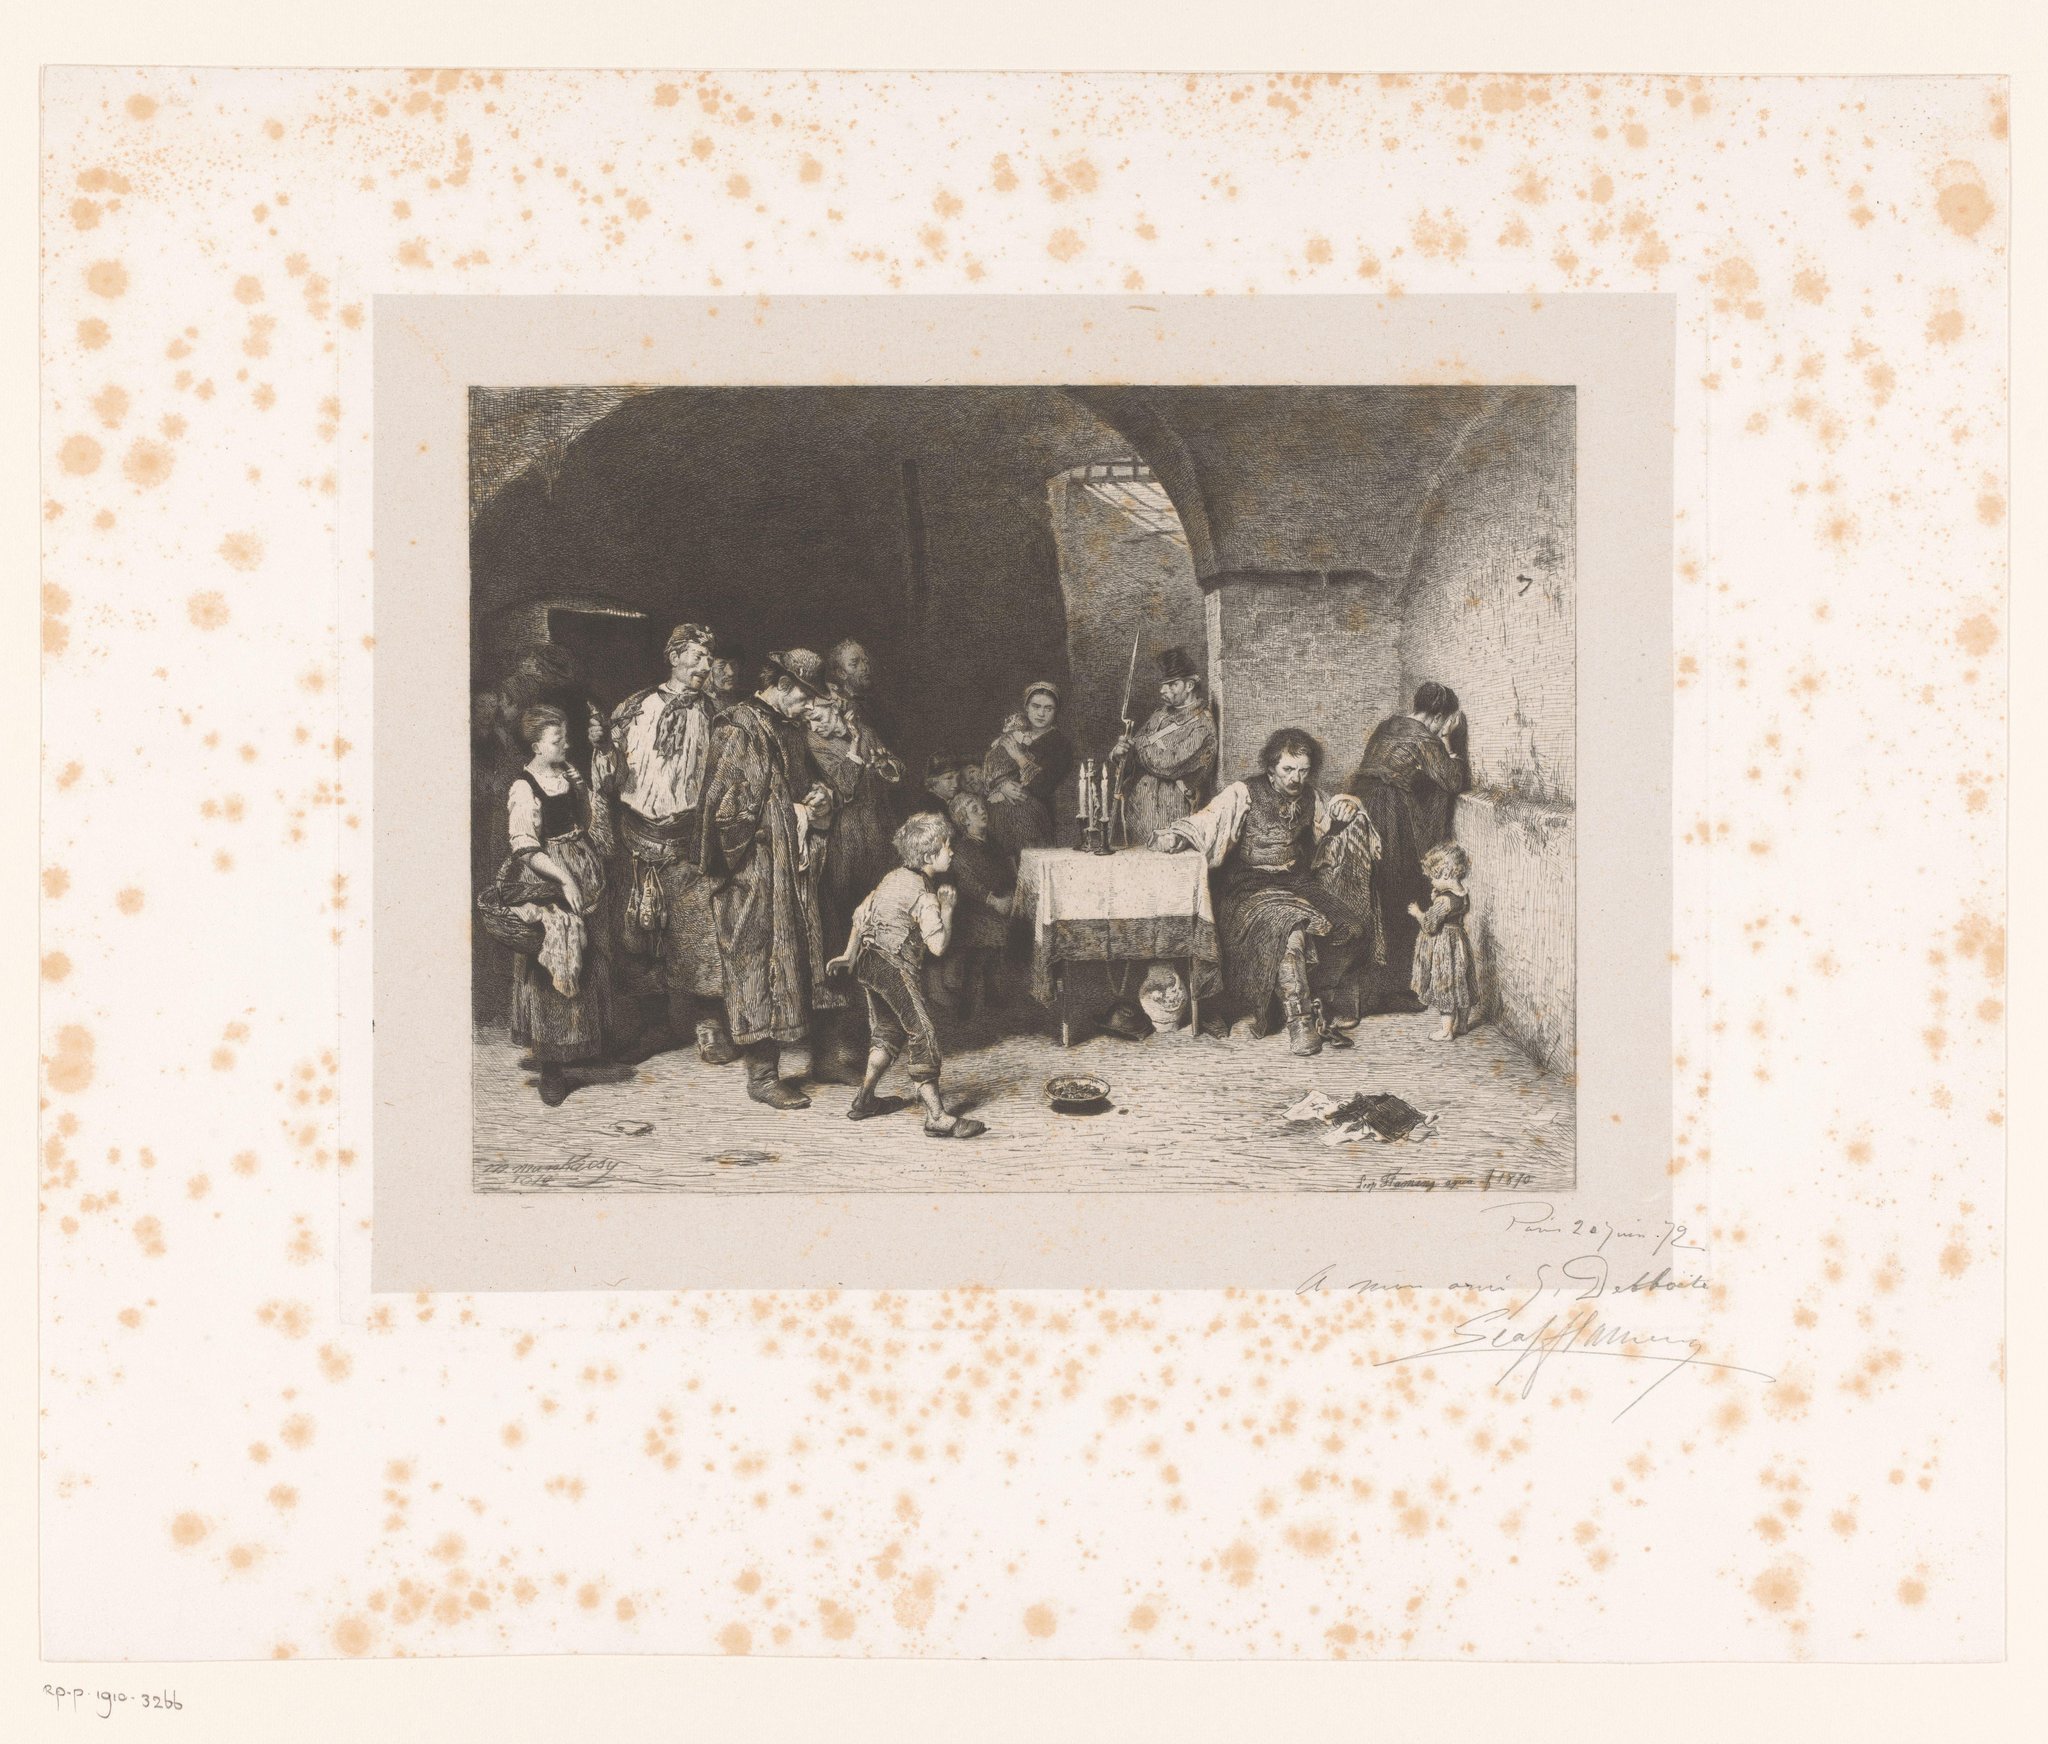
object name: print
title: Ter dood veroordeelde man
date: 1870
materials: paper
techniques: etching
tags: last hours before execution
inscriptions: collector's mark: Lugt 2228, annotation: ‘Paris 20 juin 72 / A mon ami J. Delboëte / [signatuur]’